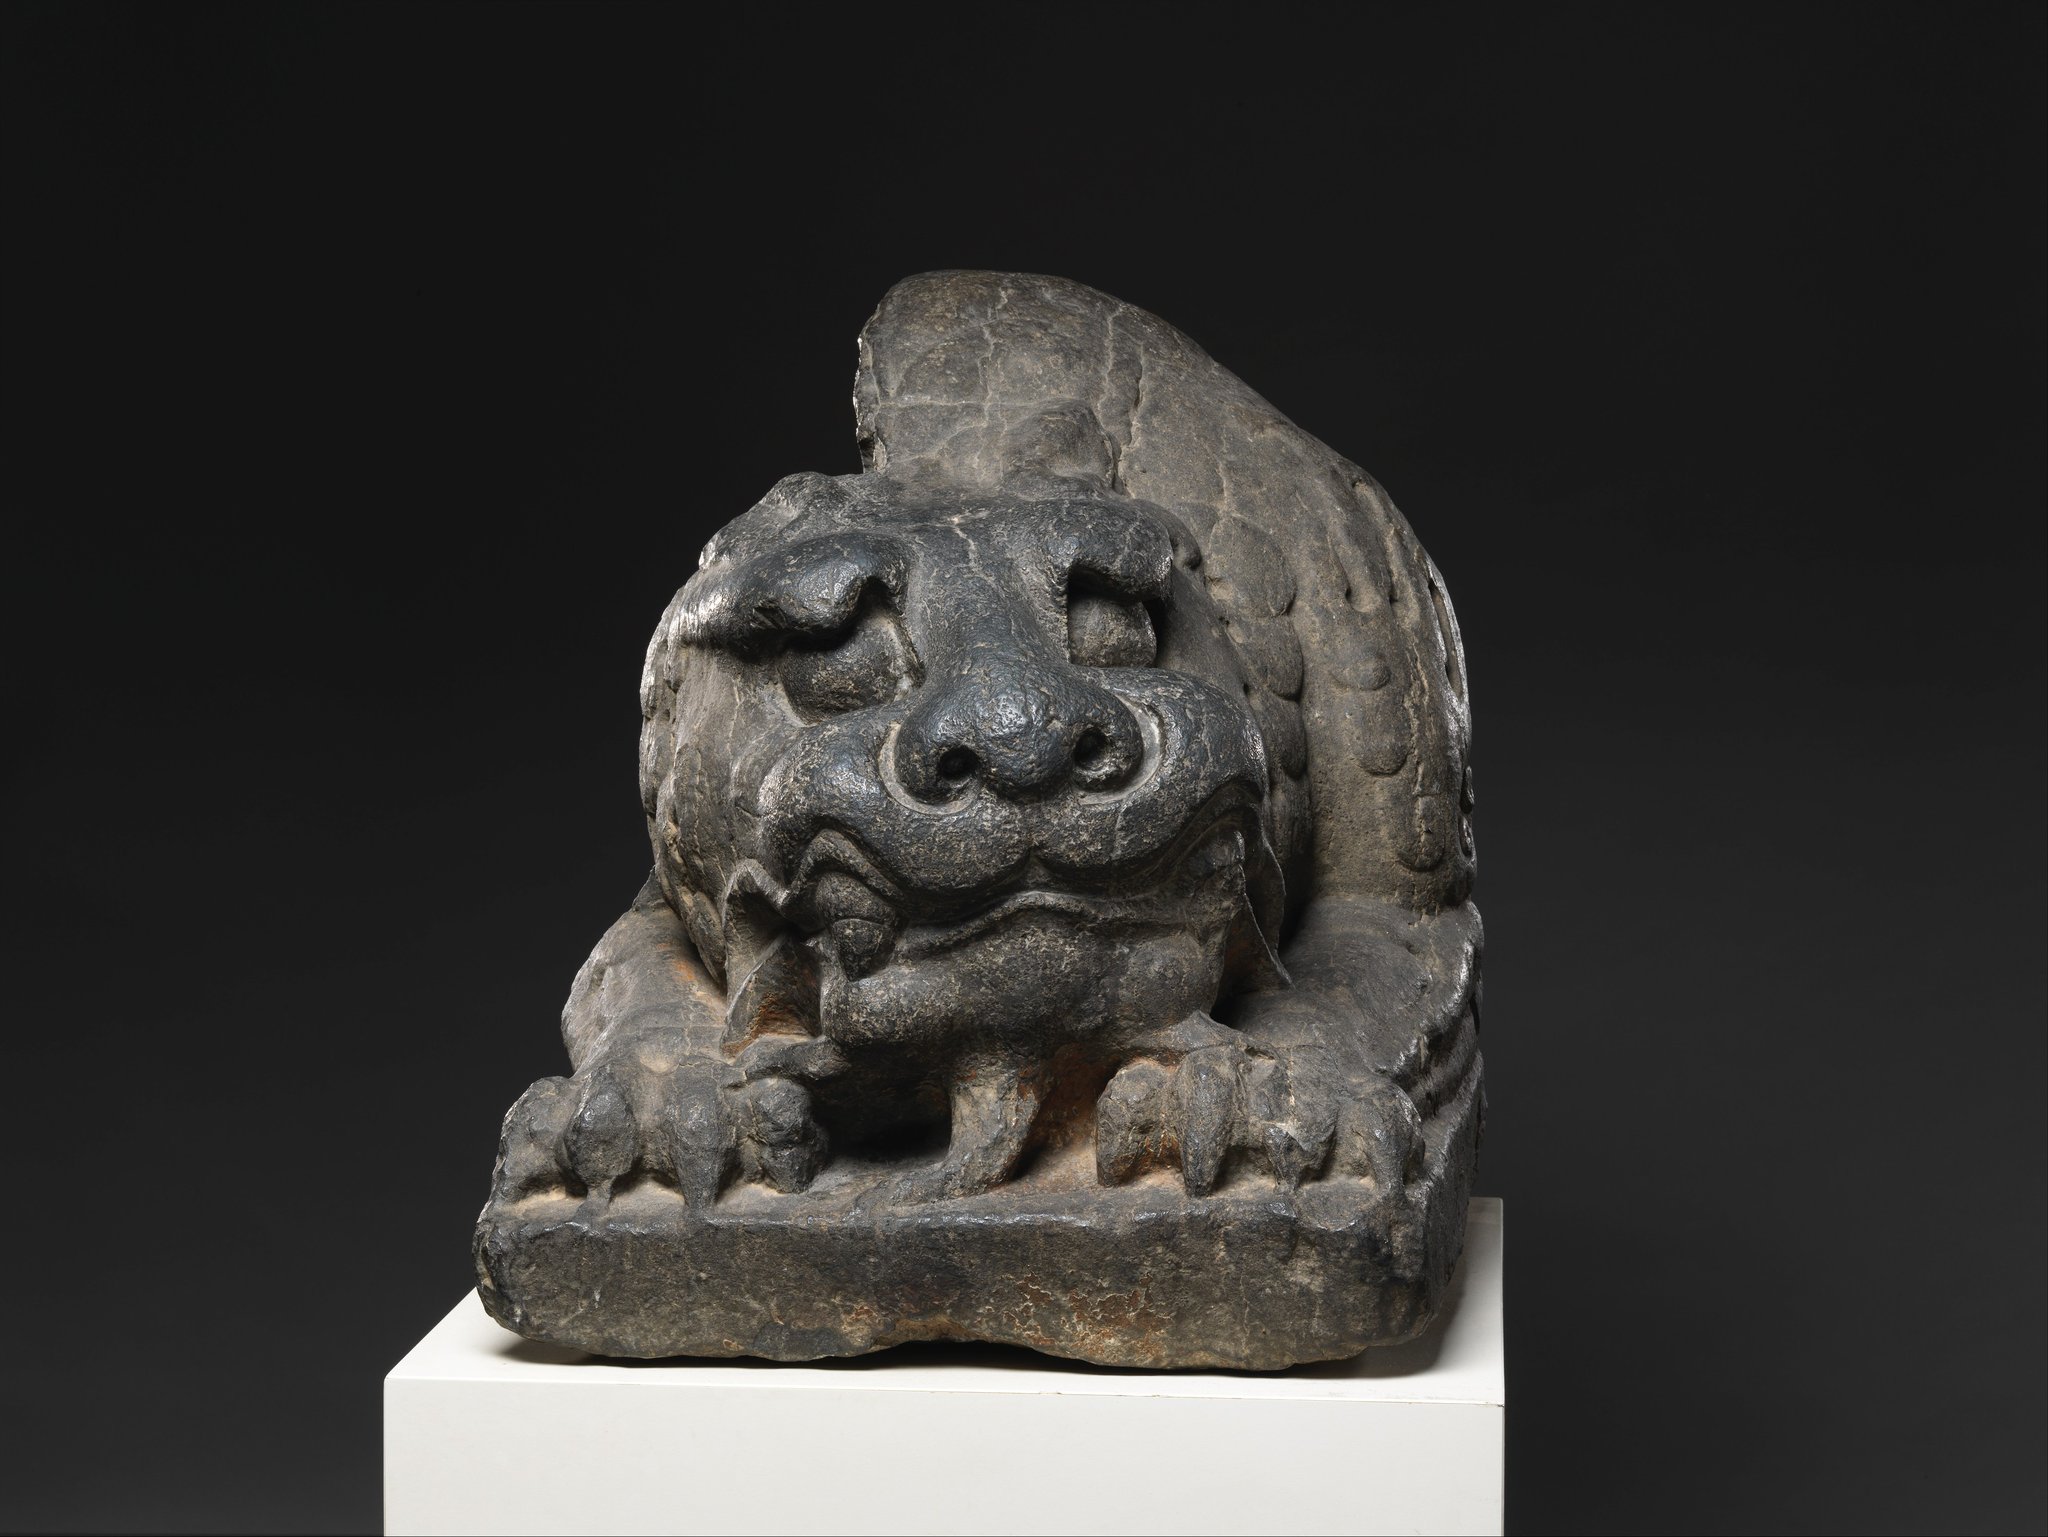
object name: figure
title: Guardian lion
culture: chinese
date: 534-566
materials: limestone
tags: lions